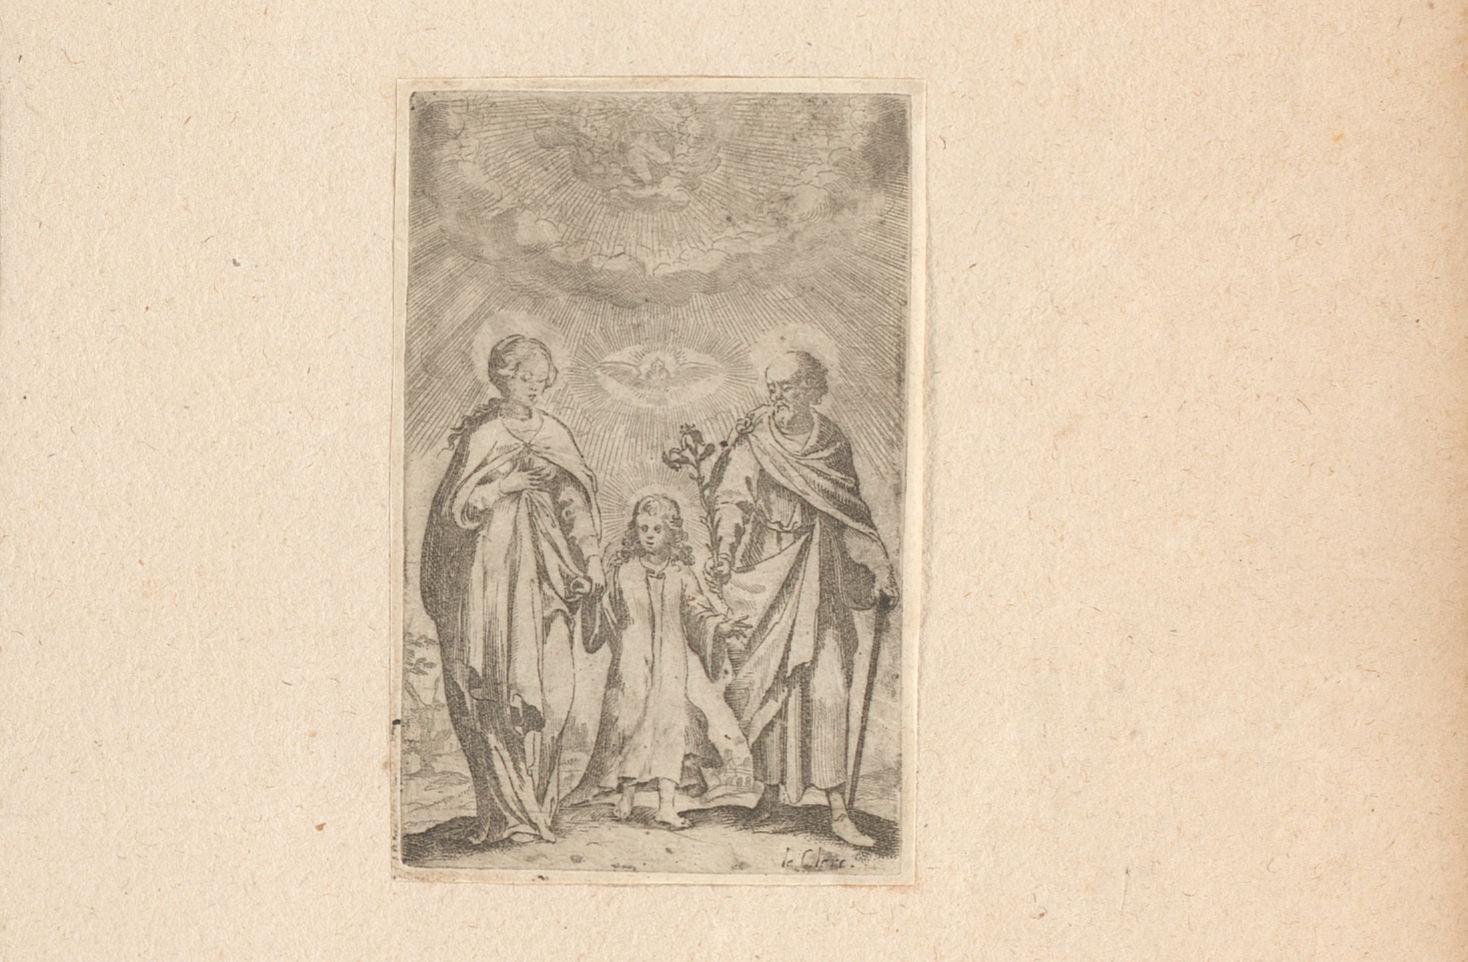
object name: album leaf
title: Heilige familie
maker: sébastien leclerc (i)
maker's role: print maker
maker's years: 1637-1714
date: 1654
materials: paper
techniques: etching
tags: holy family (alone), 'trinitas terrestris'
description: Dit betreft een prent uit een gebedenboek met de titel 'Les Sept Offices avec les Litanies Dirigées (...)'.